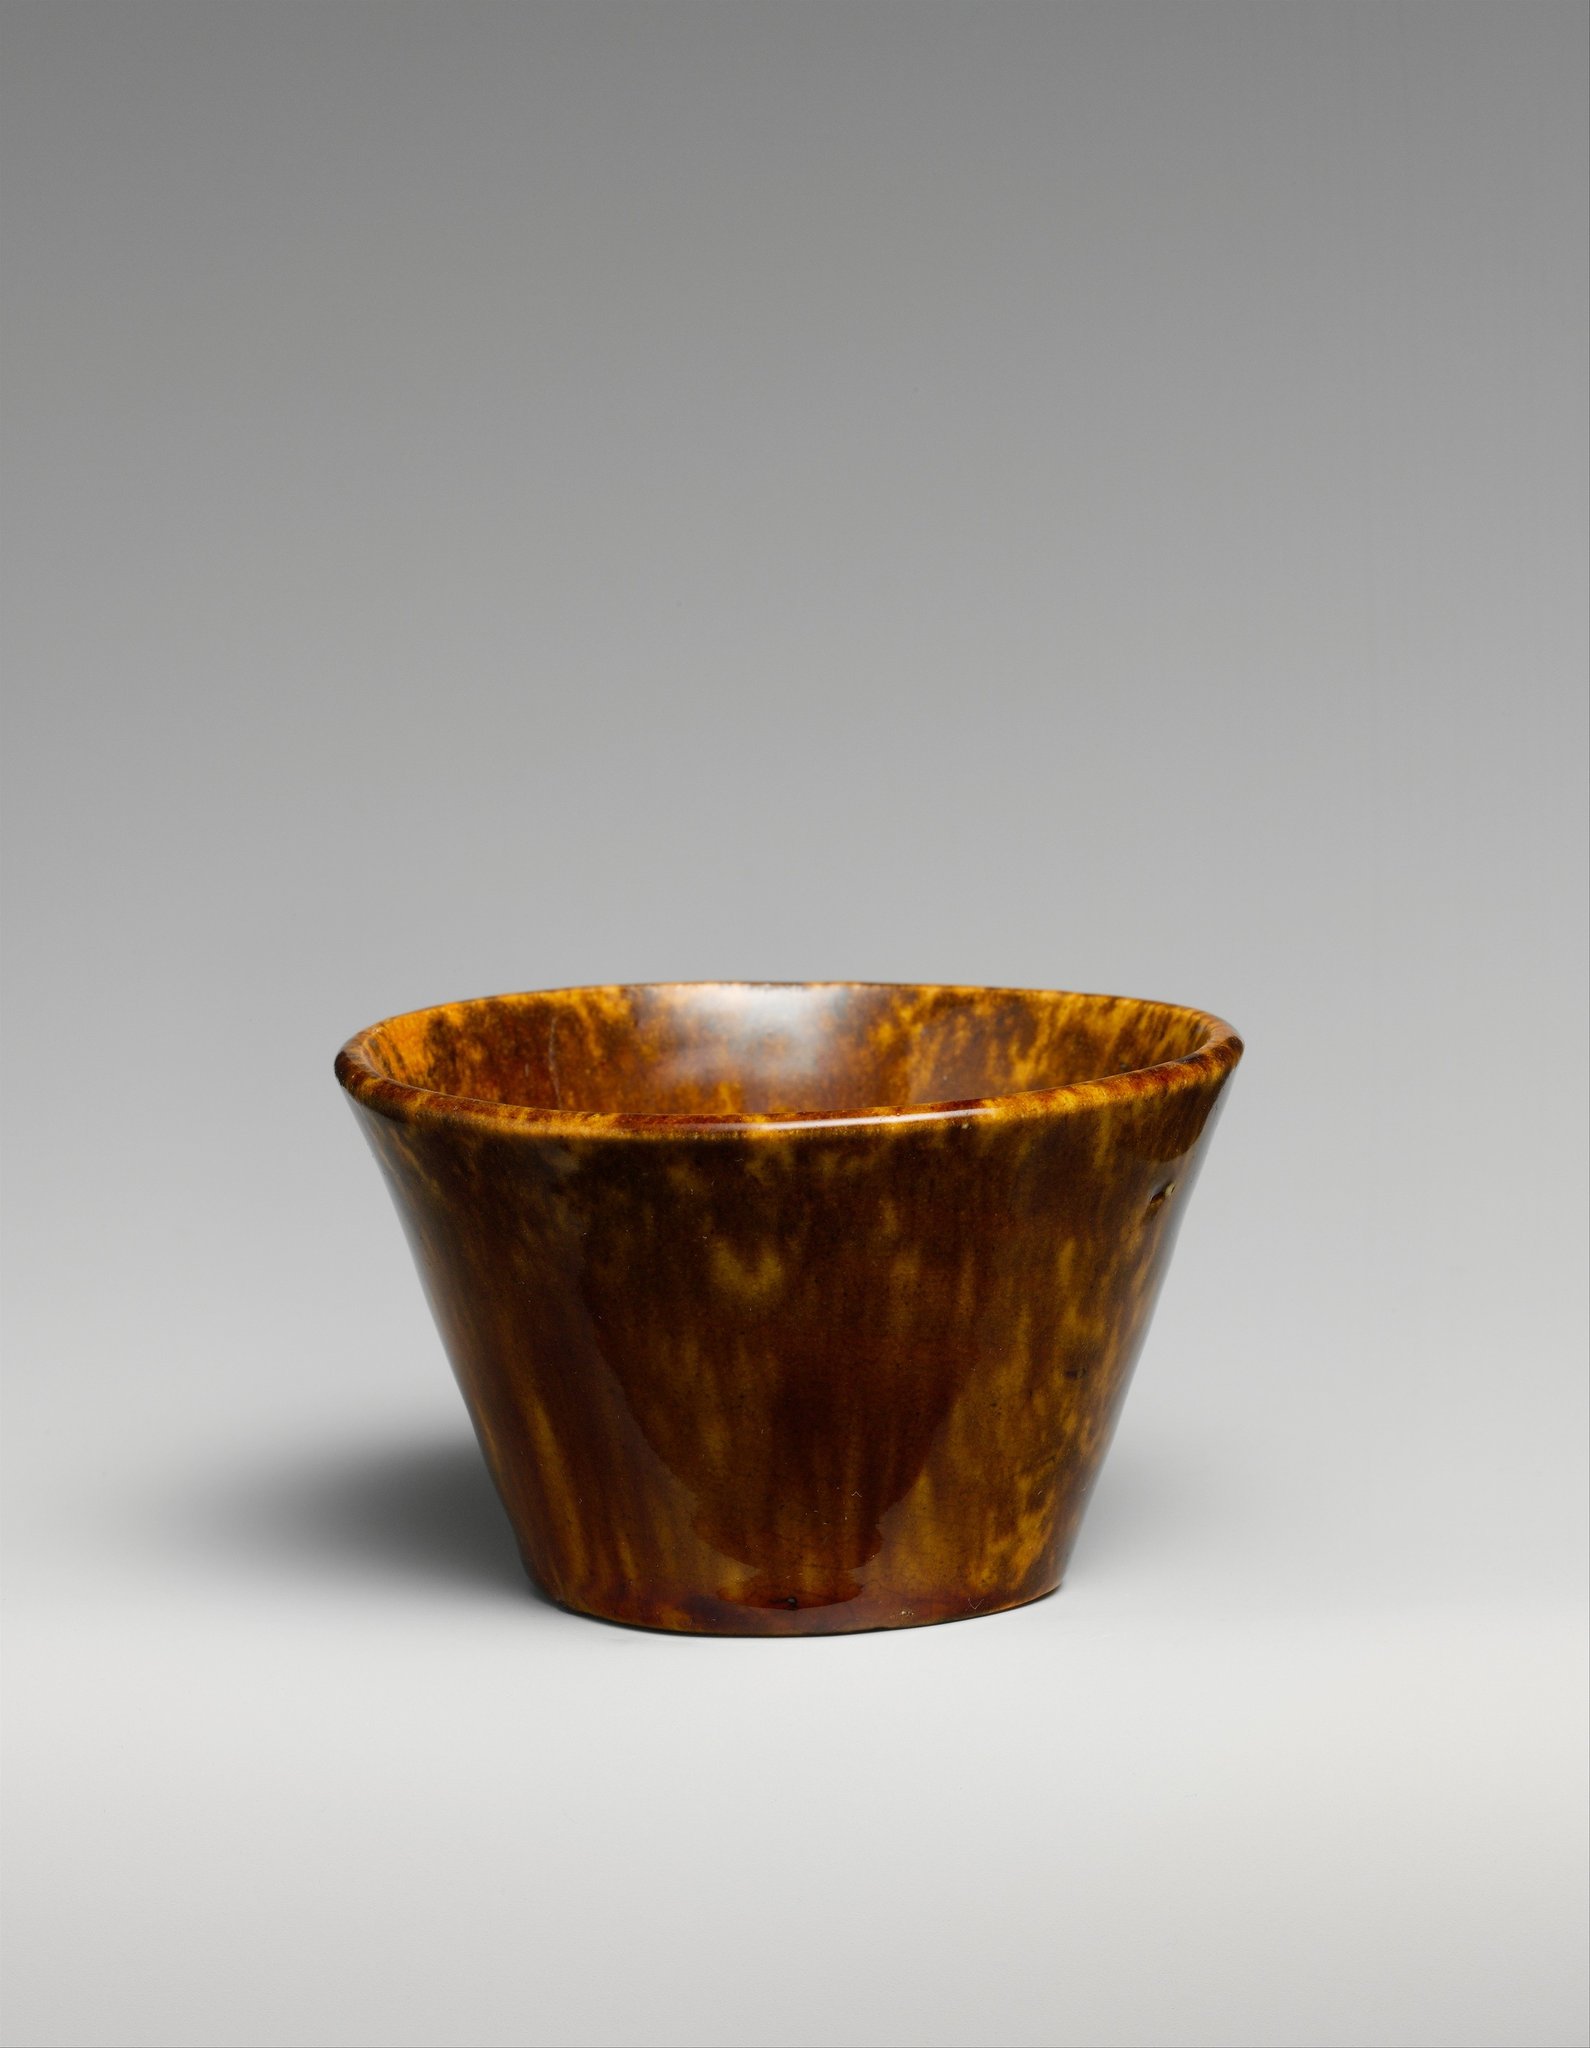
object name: cup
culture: american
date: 1850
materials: earthenware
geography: united states